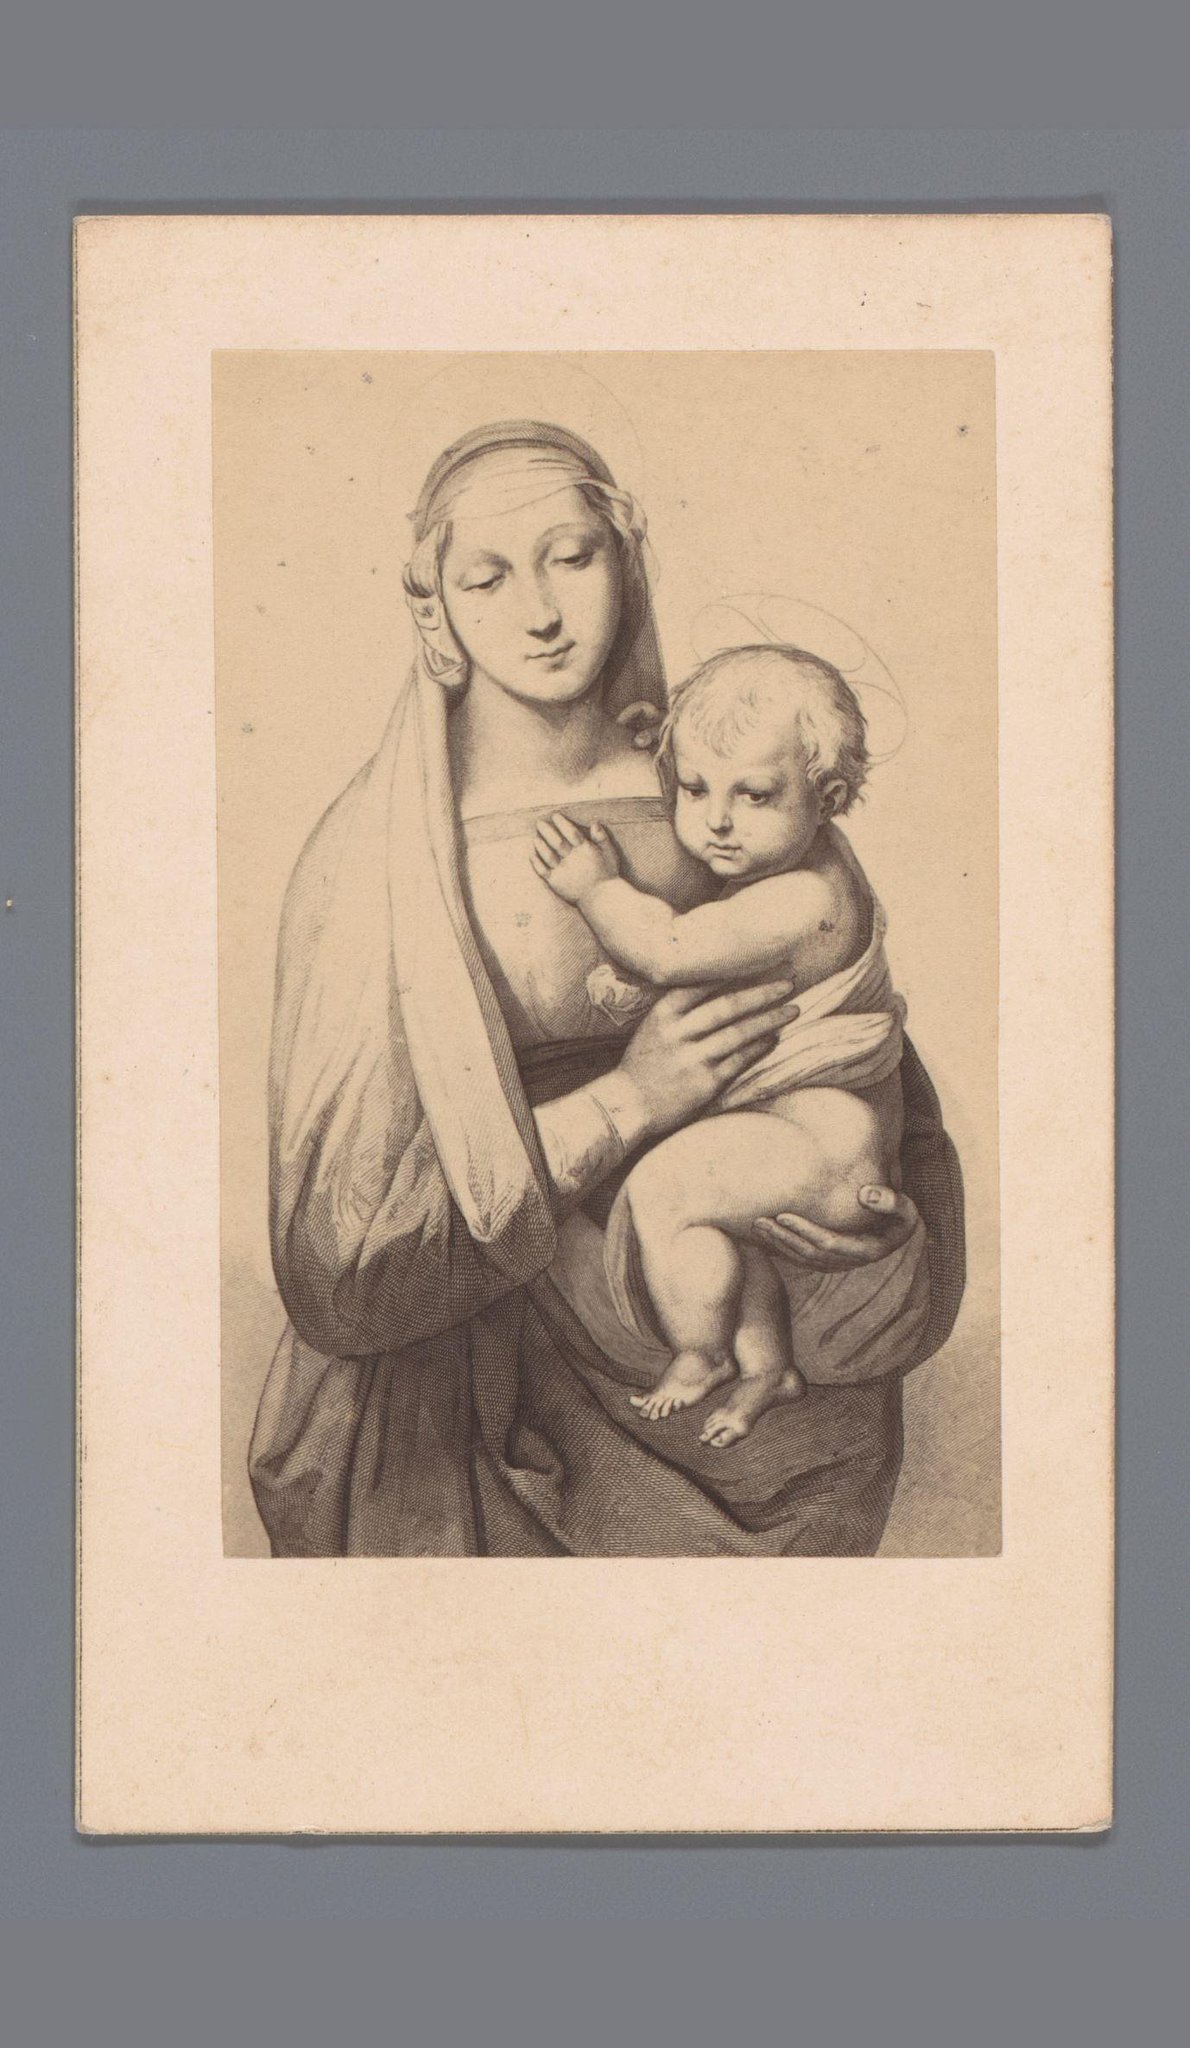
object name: photograph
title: La Madone du Grand-Duc / Madonna di Gran Duca / Die Madonna des Grossherzogs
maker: Anonymous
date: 1855-1885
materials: cardboard, paper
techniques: albumen print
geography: paris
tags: madonna: mary standing (or half-length), christ-child close to her bosom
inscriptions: inscription: ‘La gravure est de St./ 30 x 21’, number: ‘No 334’, inscription: ‘Goupil & Cie/ Éditeurs/ 9, rue Chaptal, 9/ Paris’, monogram: ‘G’, inscription: ‘Peint par Raphaël’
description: Rafaëls Madonna met kind bevindt zich in het Palazzo Pitti in Florence.